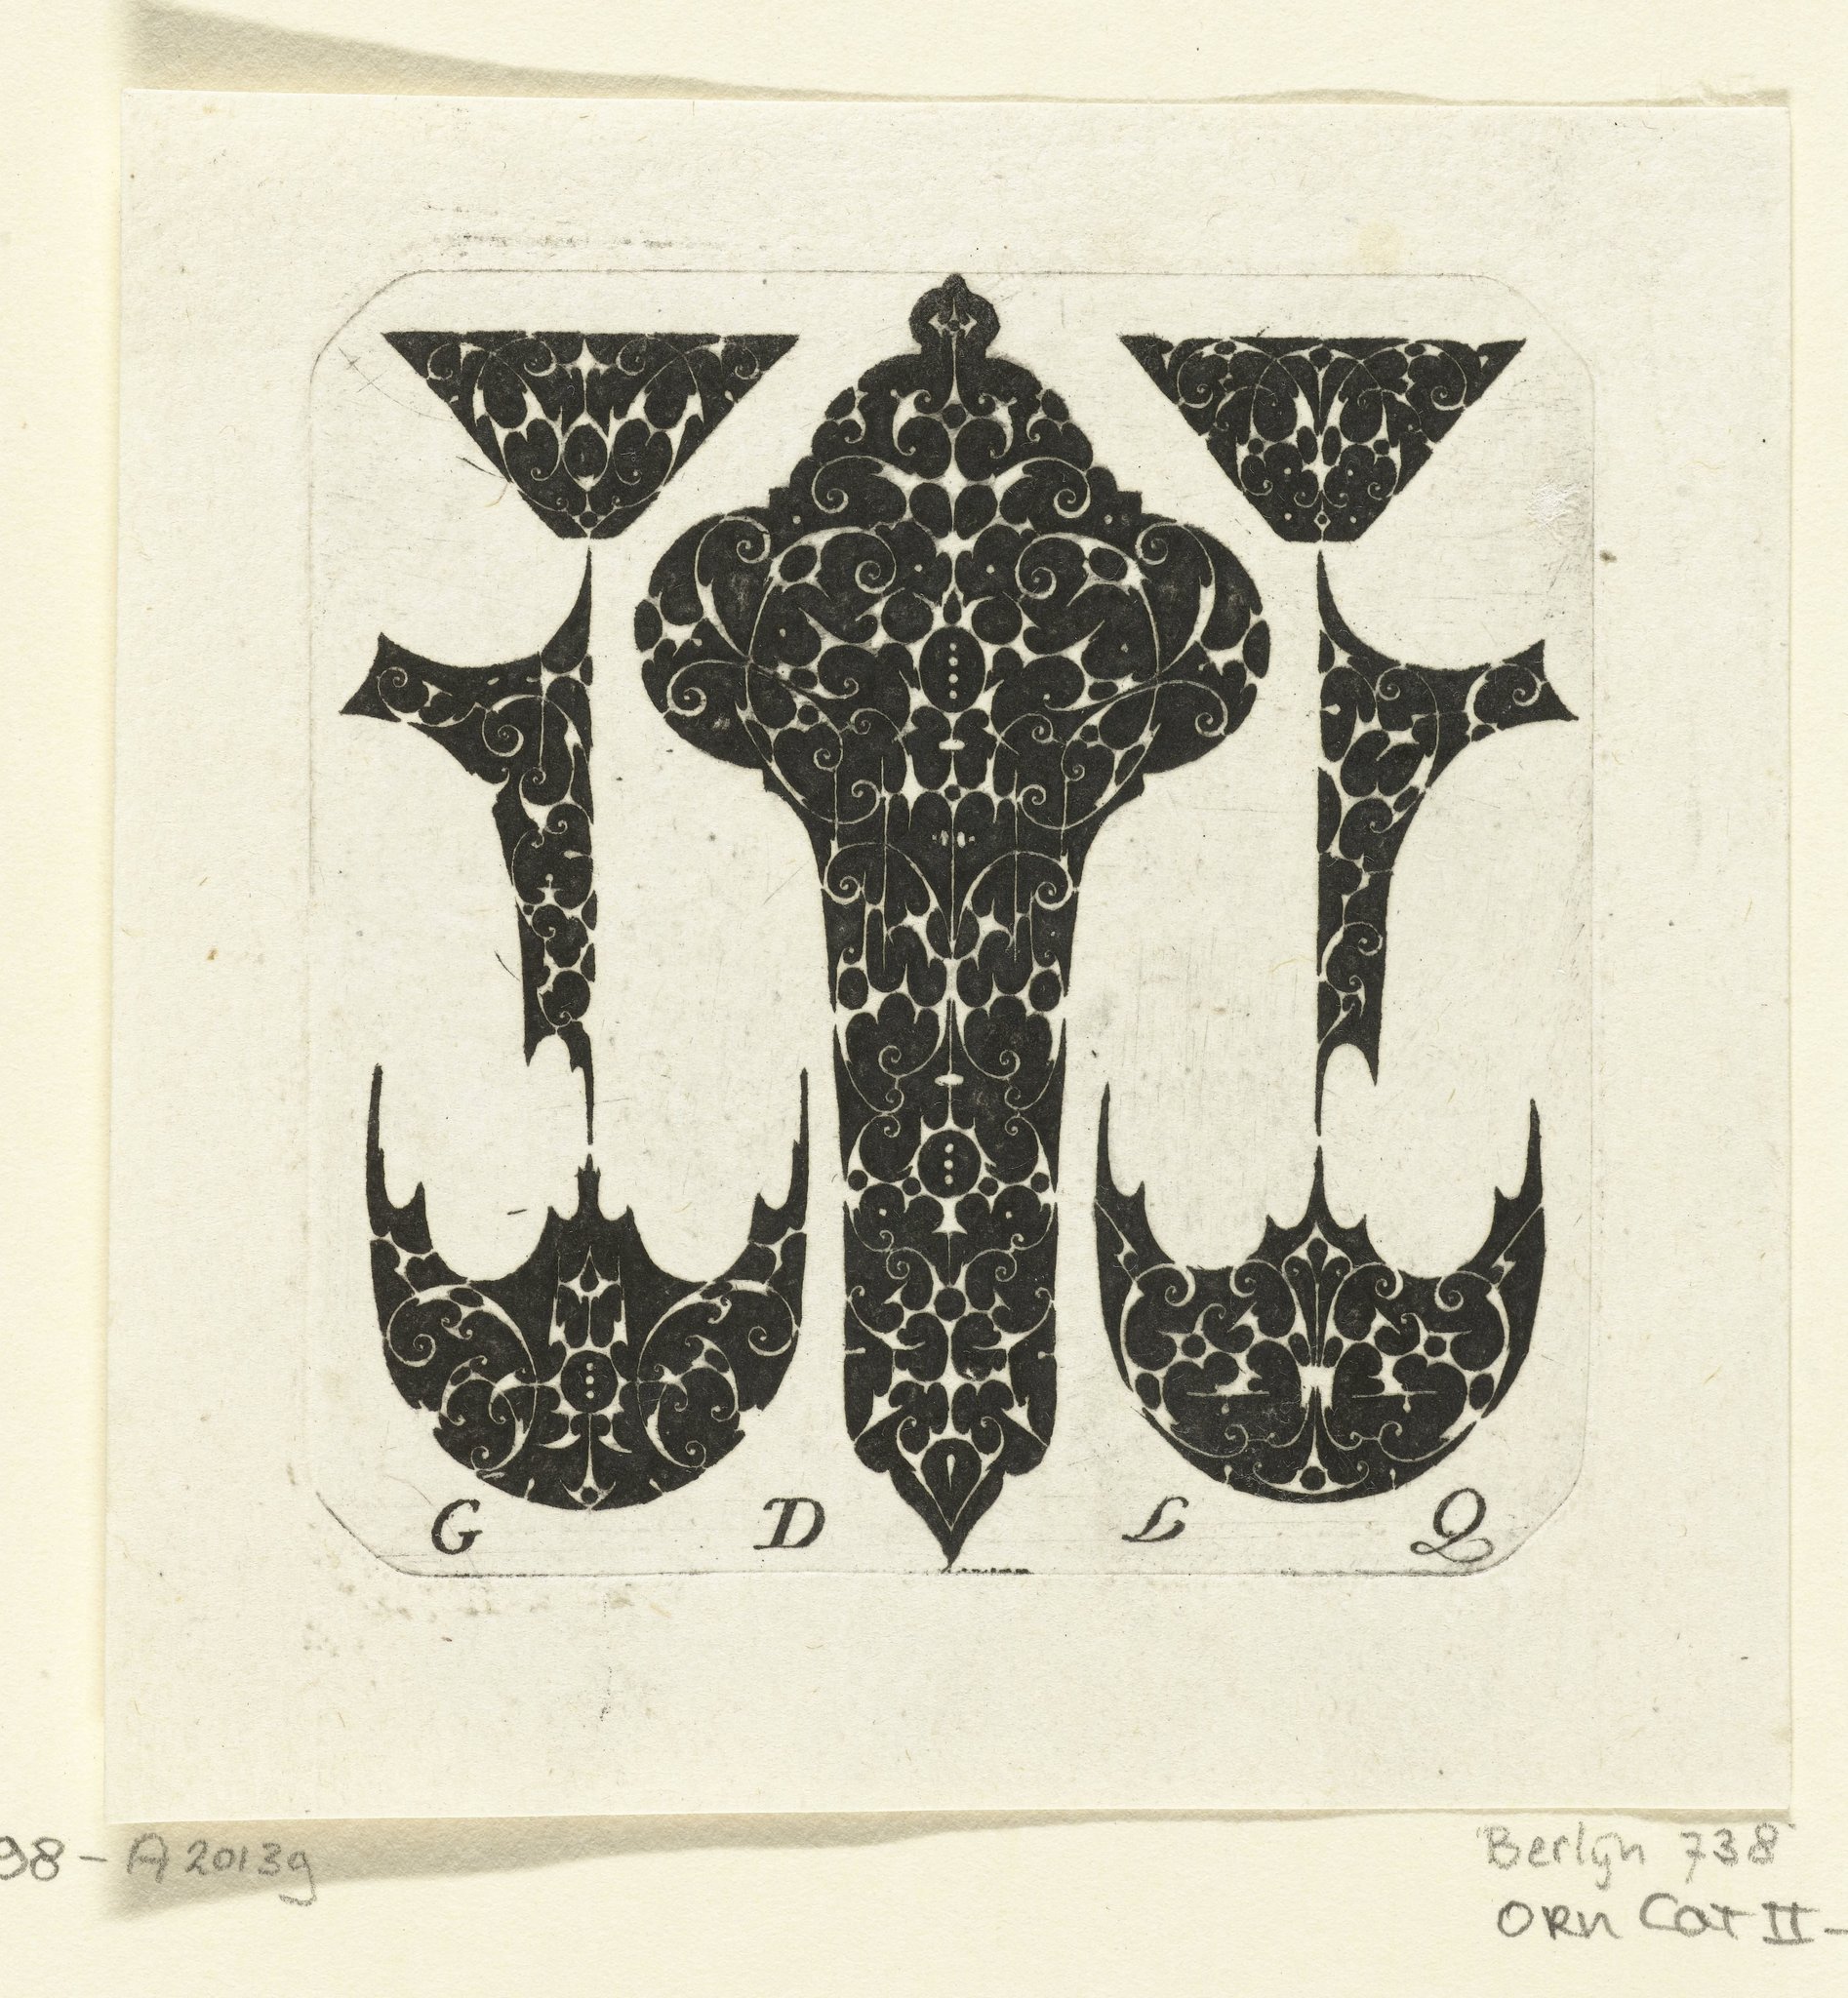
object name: ornament print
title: Sieraadontwerpen voor emailleurs in de vorm van zwartornamenten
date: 1611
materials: paper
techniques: engraving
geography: amsterdam